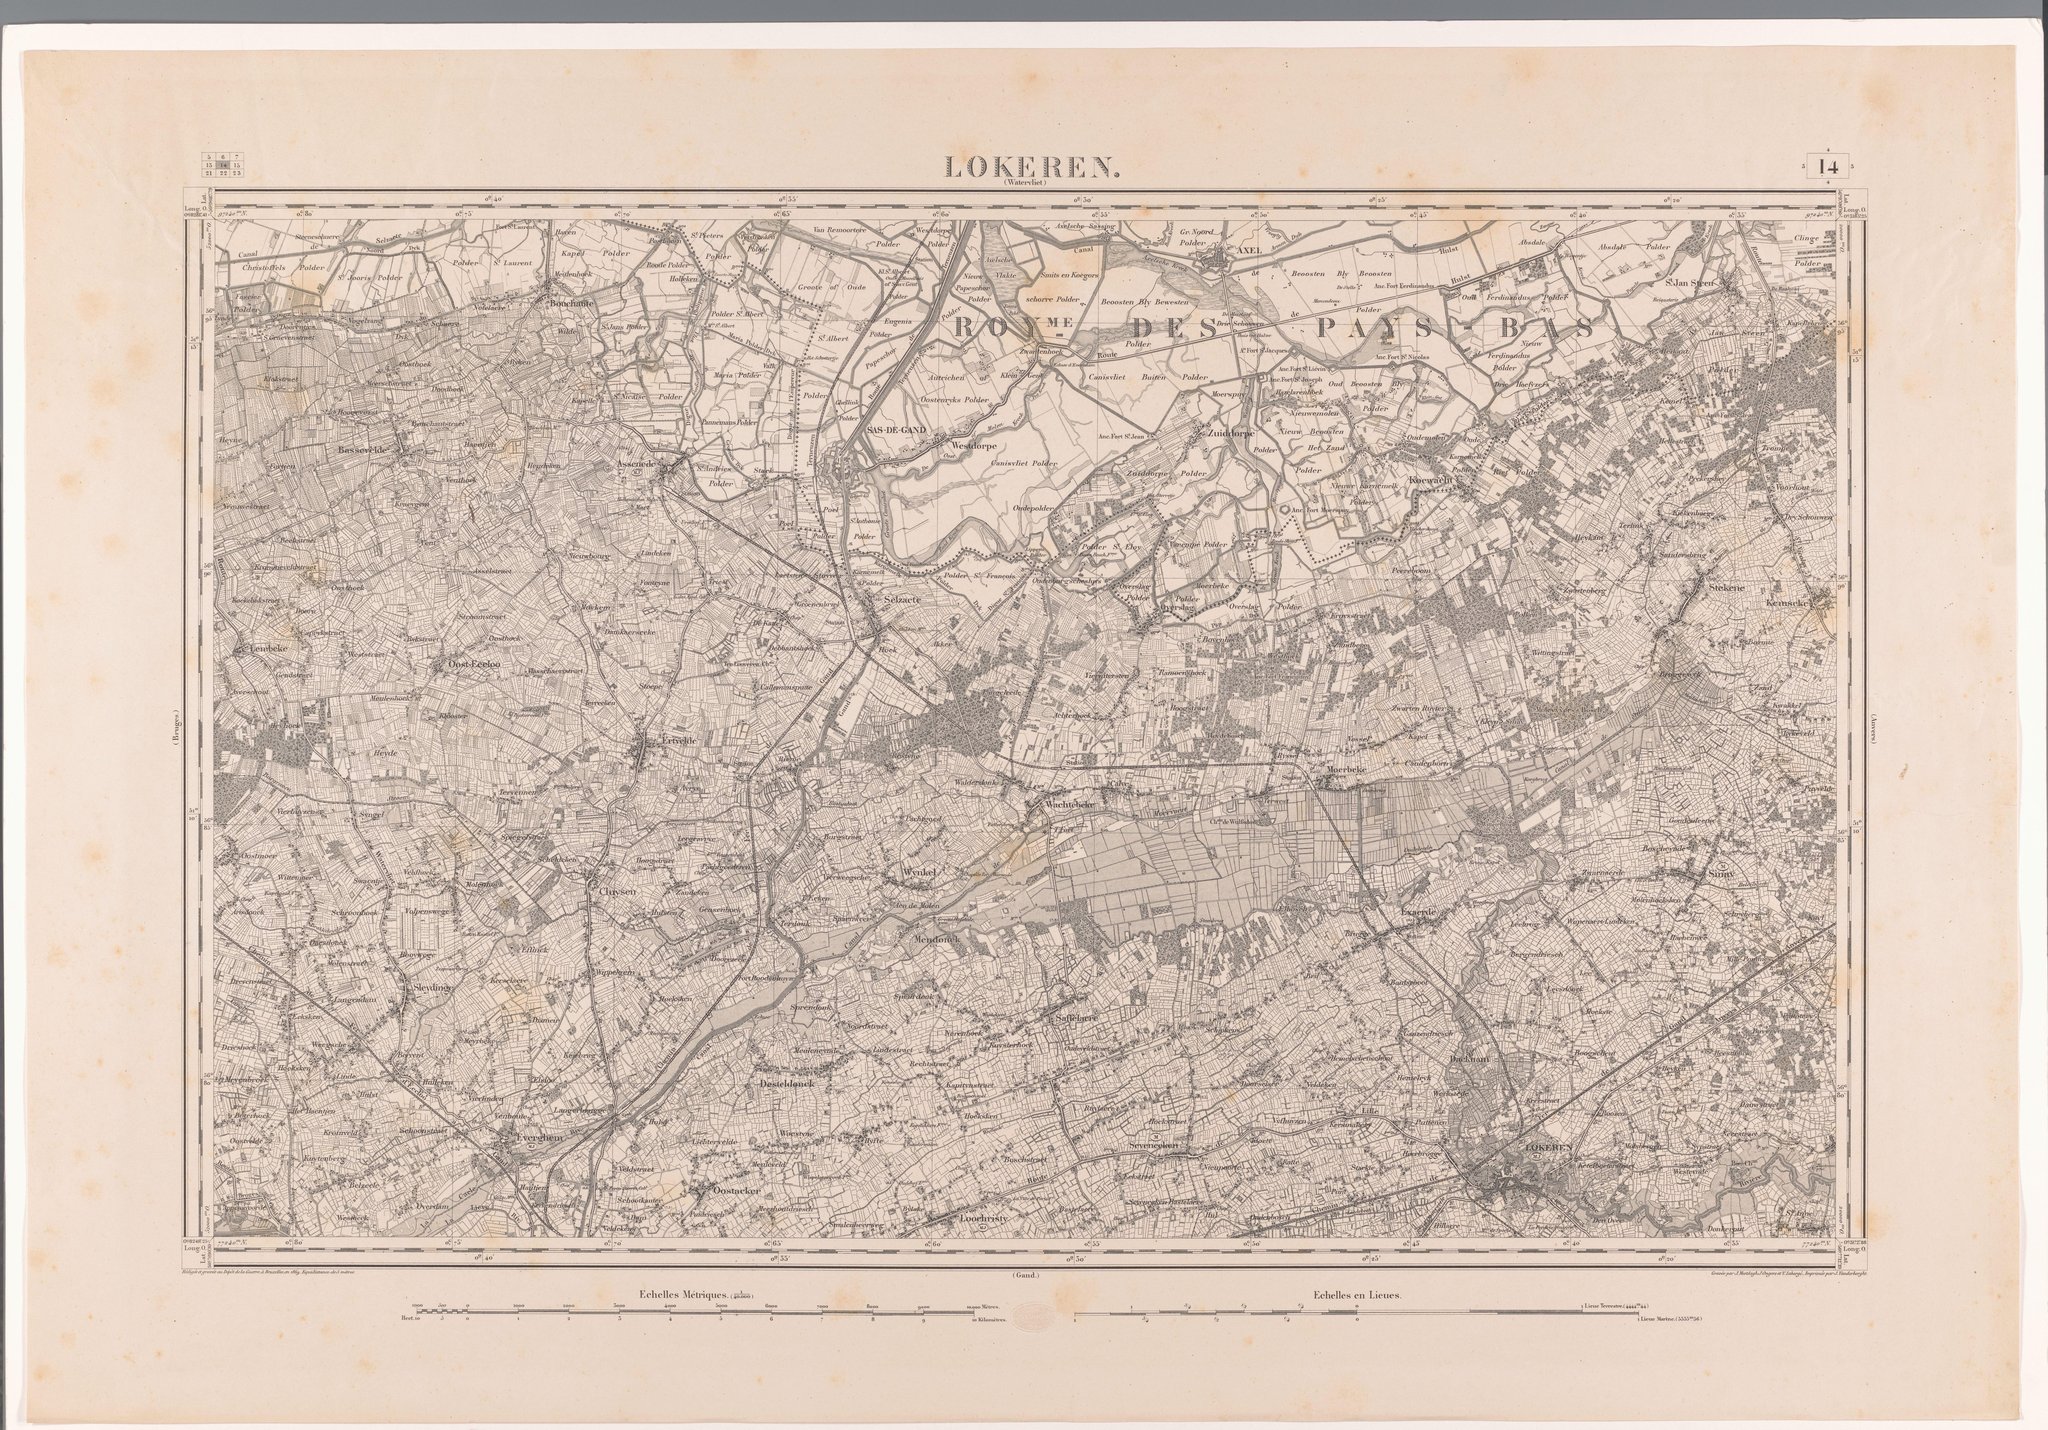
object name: map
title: Kaart van het gebied ten noordwesten van Lokeren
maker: j. vanderborght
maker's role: printer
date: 1869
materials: paper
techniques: lithograph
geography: brussels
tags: maps of separate countries or regions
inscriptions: check stamp: ‘Depot de la Guerre Belgique’